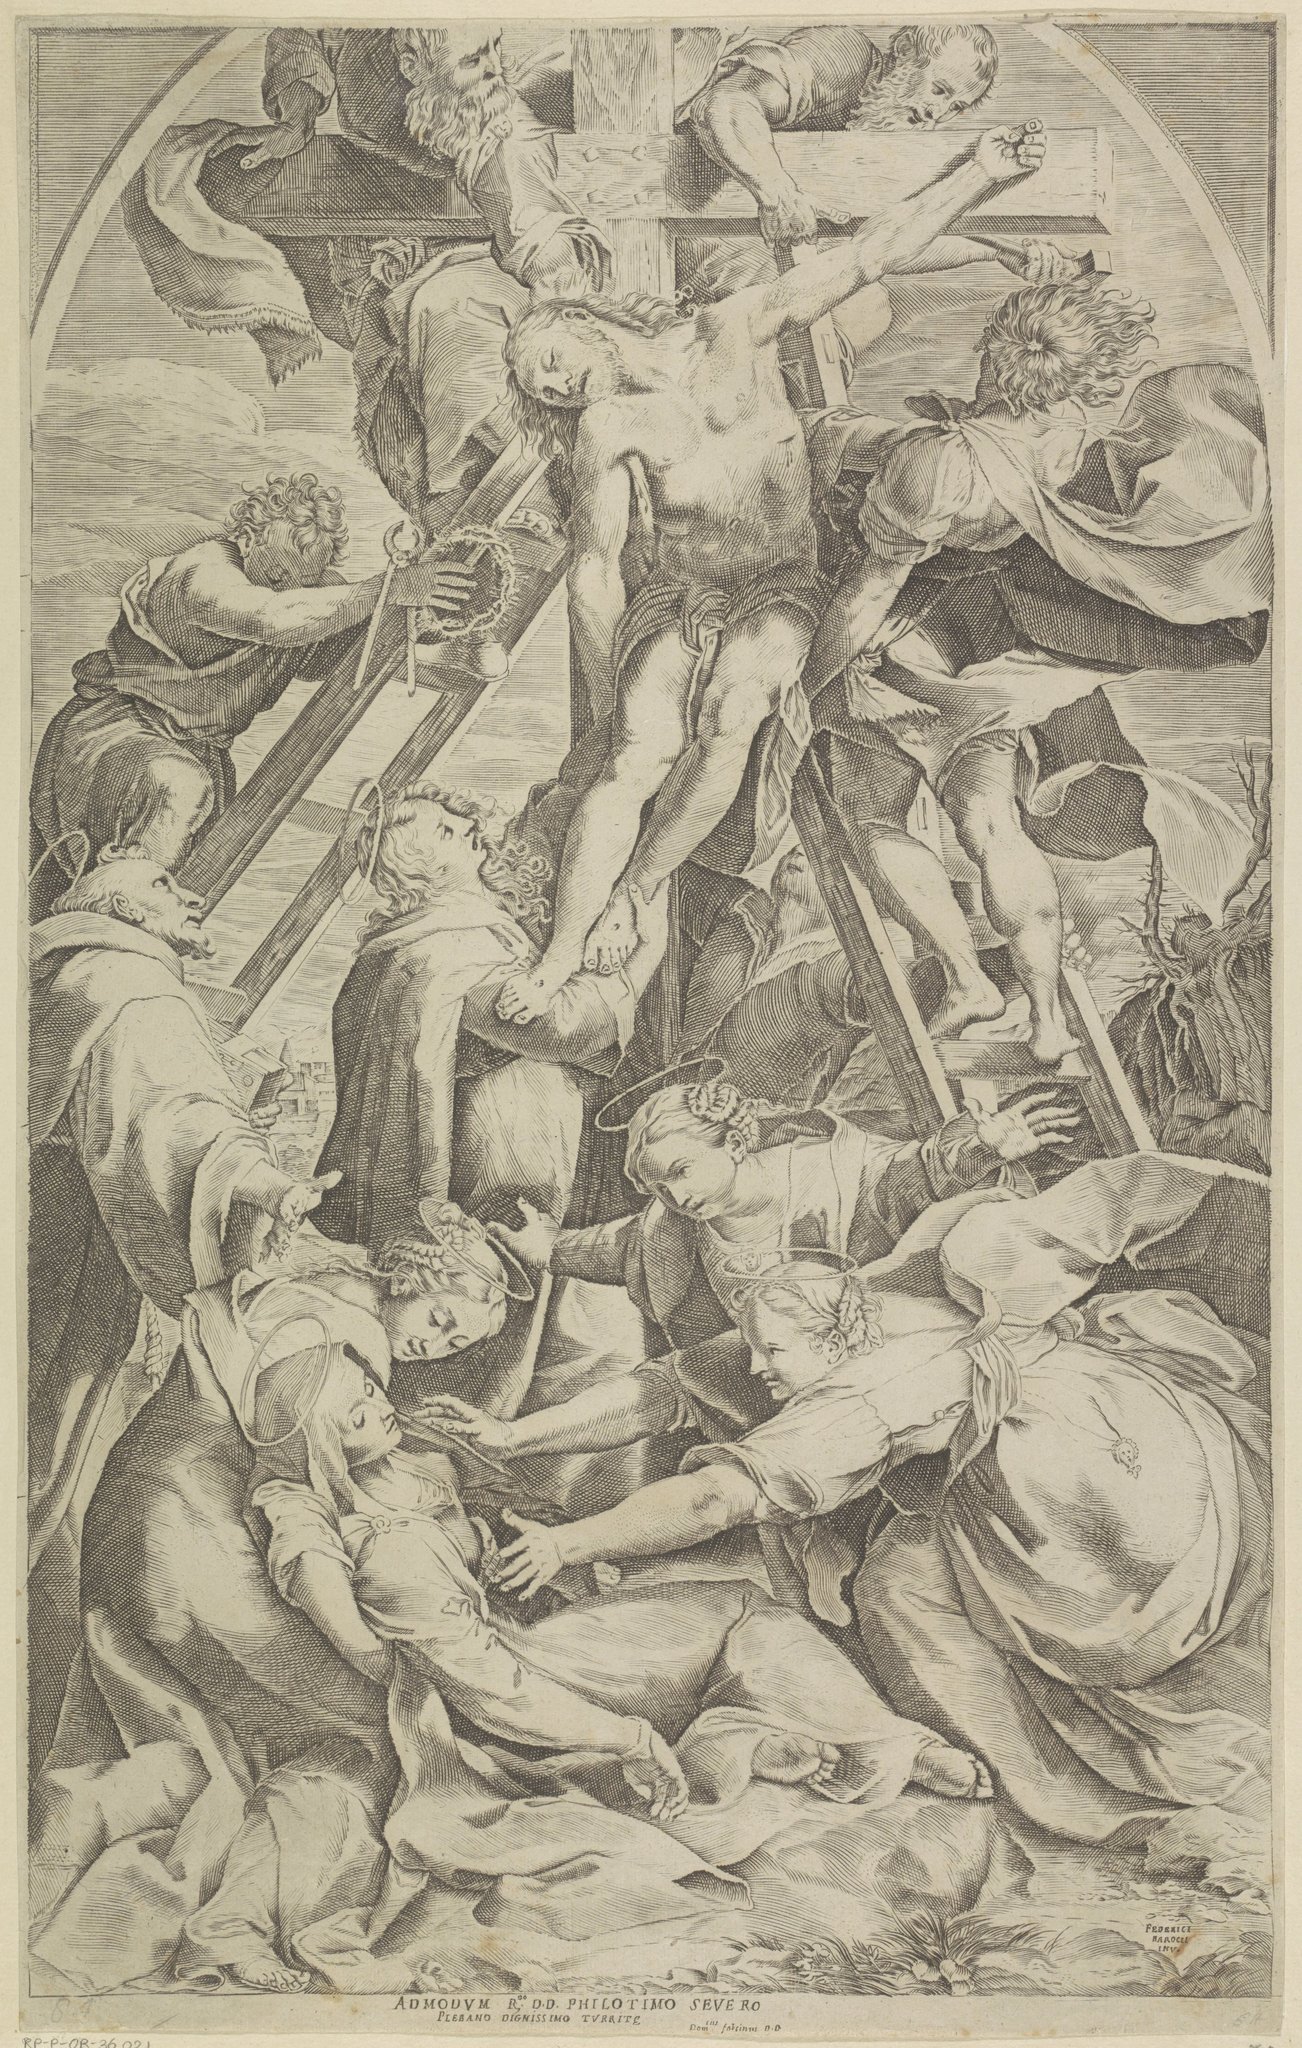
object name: print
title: Kruisafname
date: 1585-1631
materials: paper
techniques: engraving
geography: italy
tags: descent from the cross: christ is taken down from the cross, usually by nicodemus and joseph of arimathaea who are standing on the ladders (both arms of christ detached)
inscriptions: collector's mark: Lugt 240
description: Het lichaam van Christus wordt van het kruis gehaald door een groep mannen op ladders, onder wie Jozef van Arimatea, Johannes de Evangelist en Nikodemus. De Maria's treuren onder het kruis.